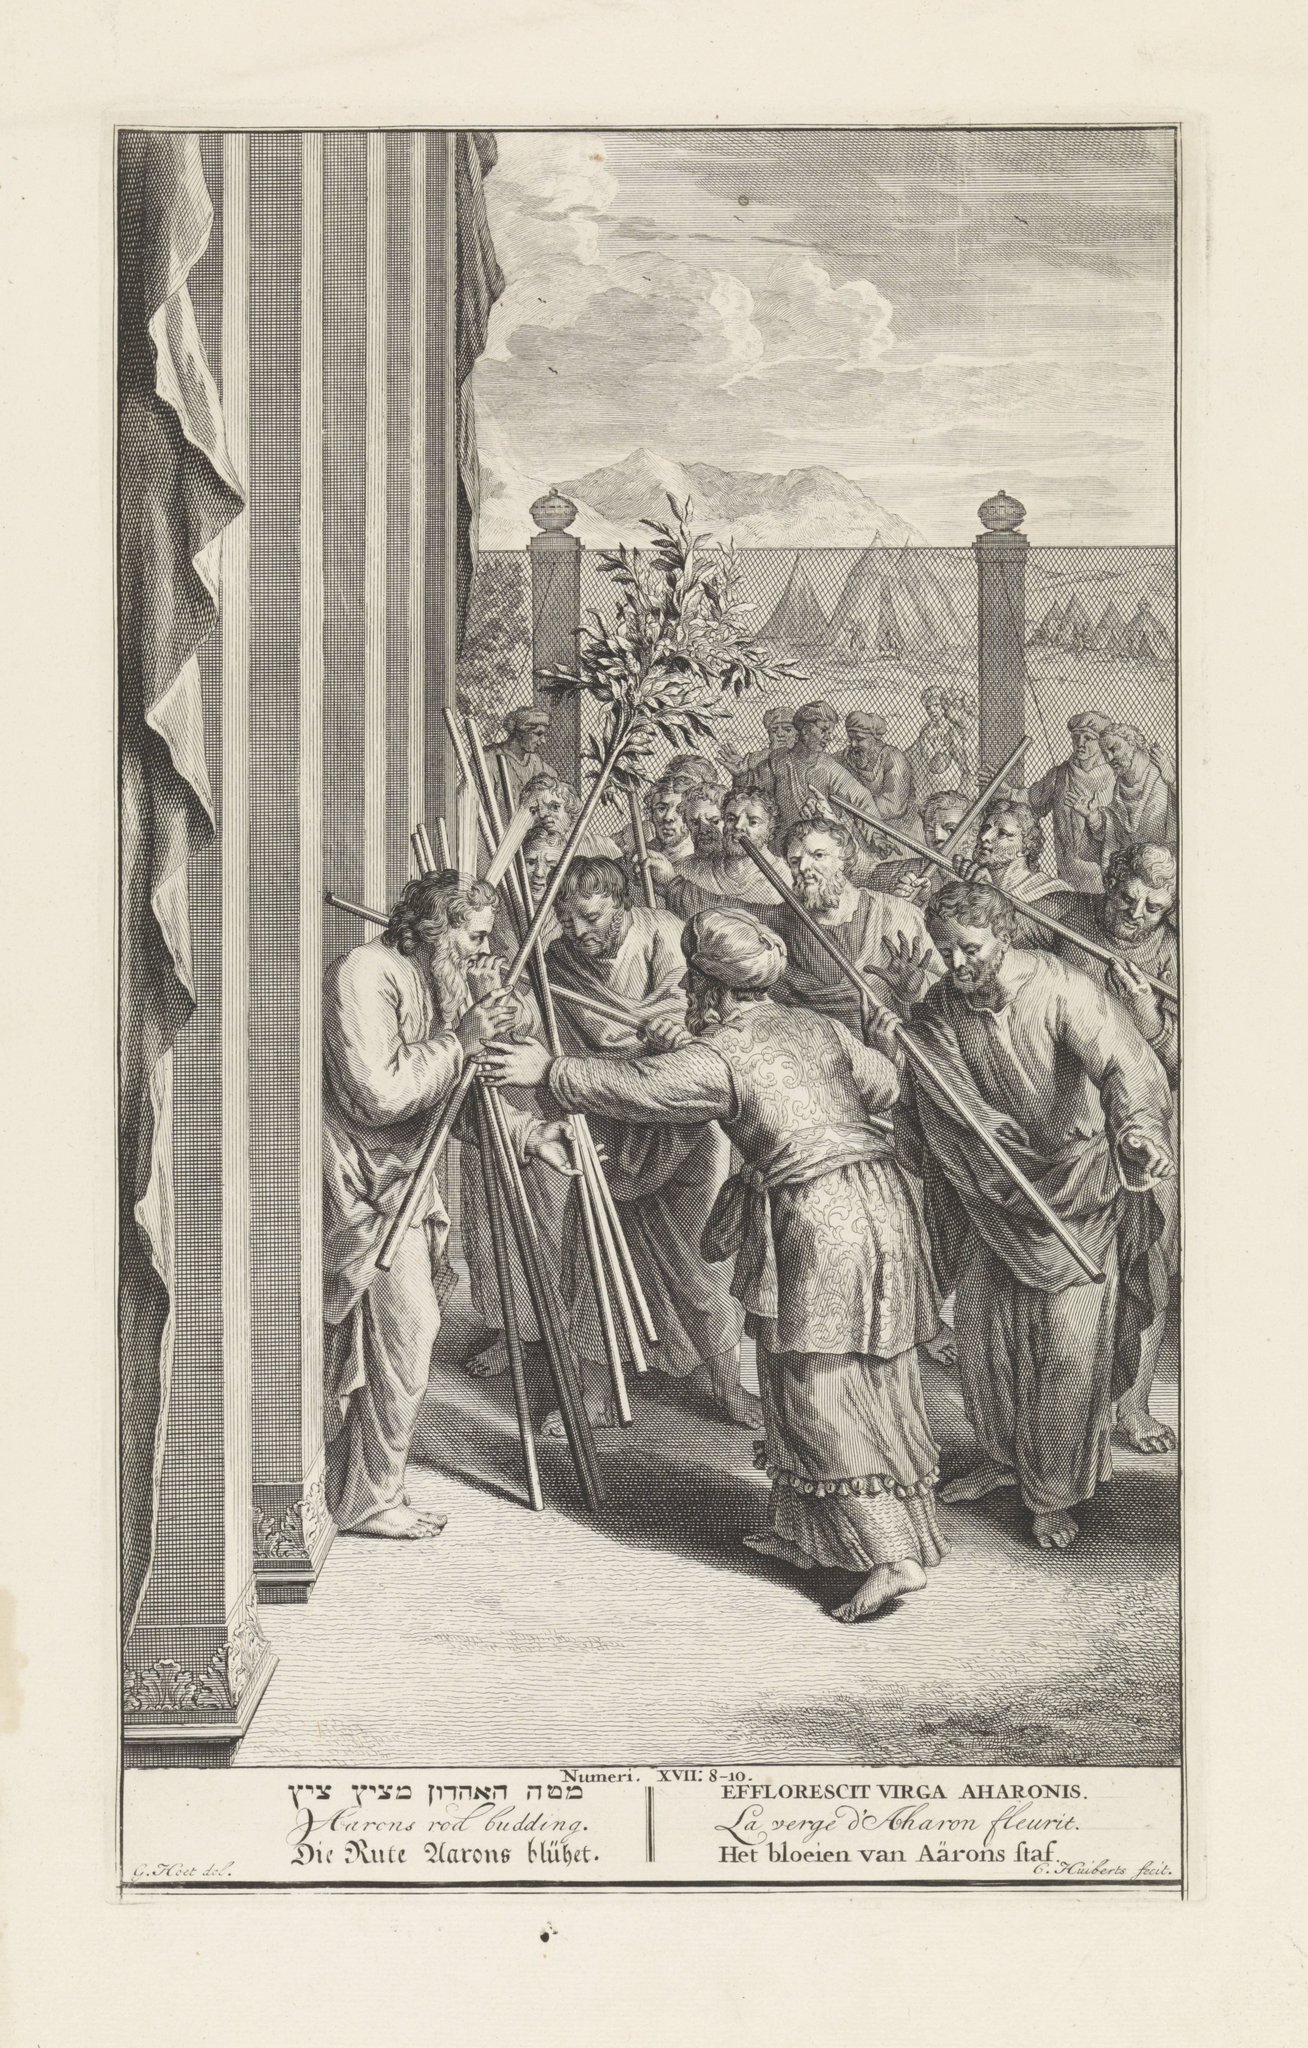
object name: book illustration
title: Mozes toont de bloeiende staf van Aäron aan de stamhoofden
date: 1720-1728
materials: paper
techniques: engraving, etching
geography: amsterdam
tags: moses shows the flowering rod of aaron to the community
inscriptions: collector's mark: Lugt 2228, inscription: ‘Utrechts Fundatie Huijs’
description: Prent gemaakt voor: Figures de la Bible. Amsterdam, Bernard Picart, 1720. Prent ook gebruikt in: Taferelen der voornaamste geschiedenissen van het Oude en Nieuwe Testament (...) door de vermaarde kunstenaars Hoet, Houbraken, en Picart getekent (...) en met beschrijvingen uitgebreid. Den Haag: Pieter de Hondt, 1728.